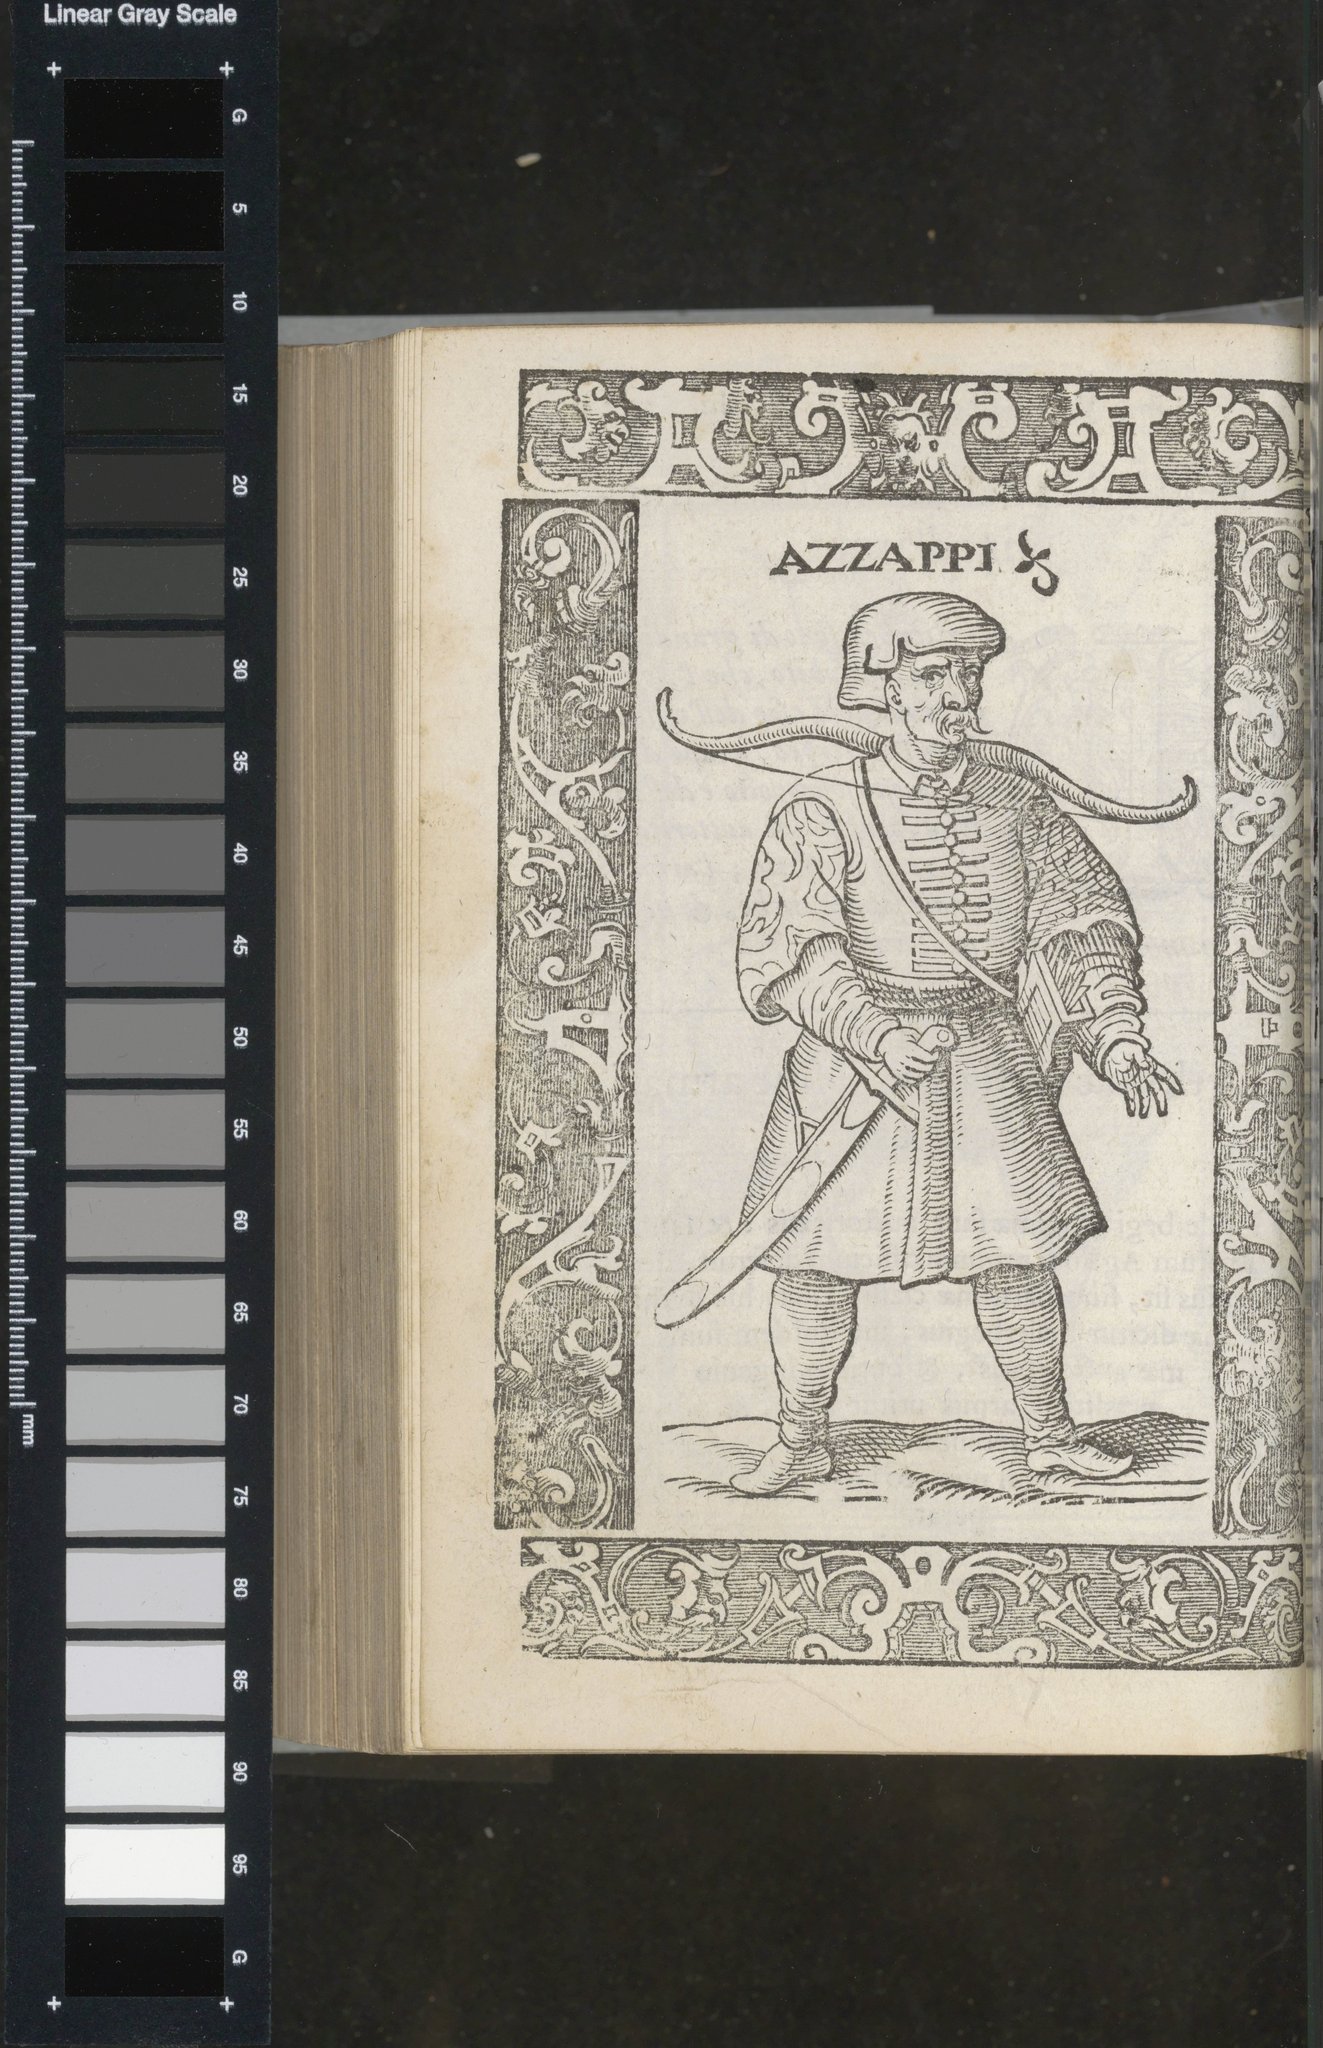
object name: costume print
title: Habiti antichi, et moderni di tutto il mondo...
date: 1598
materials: paper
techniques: woodcut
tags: fashion plates